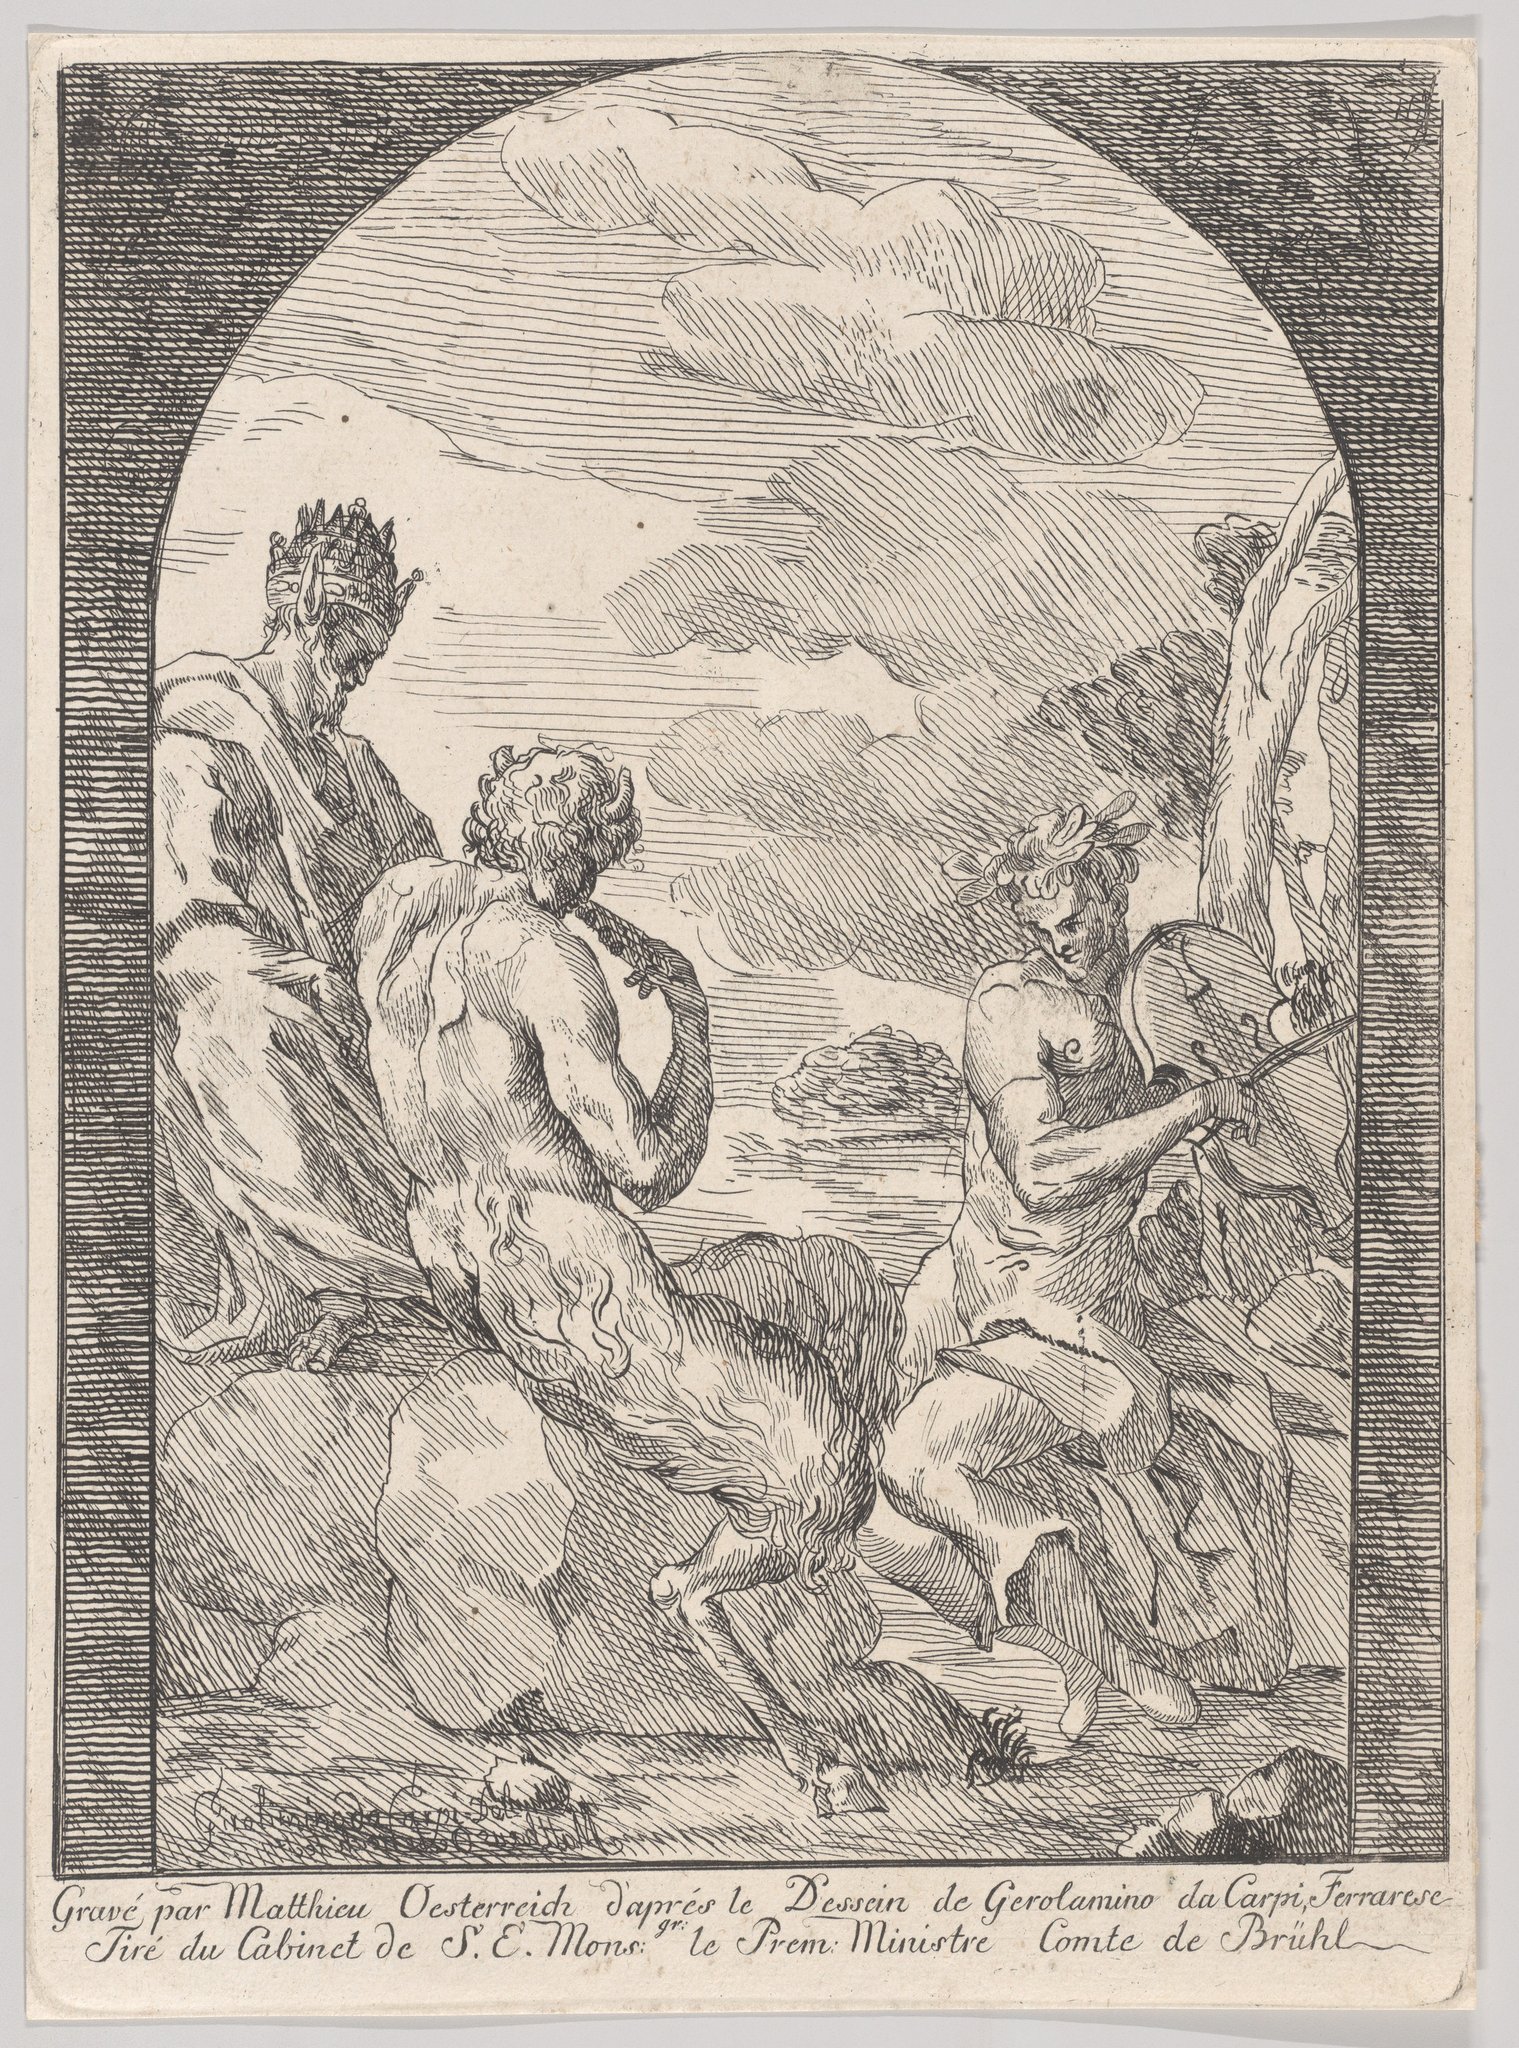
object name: print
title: Contest between Apollo and Marsyas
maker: girolamo da carpi (girolamo sellari)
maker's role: artist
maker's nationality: italian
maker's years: 1501-1556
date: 1754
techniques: etching